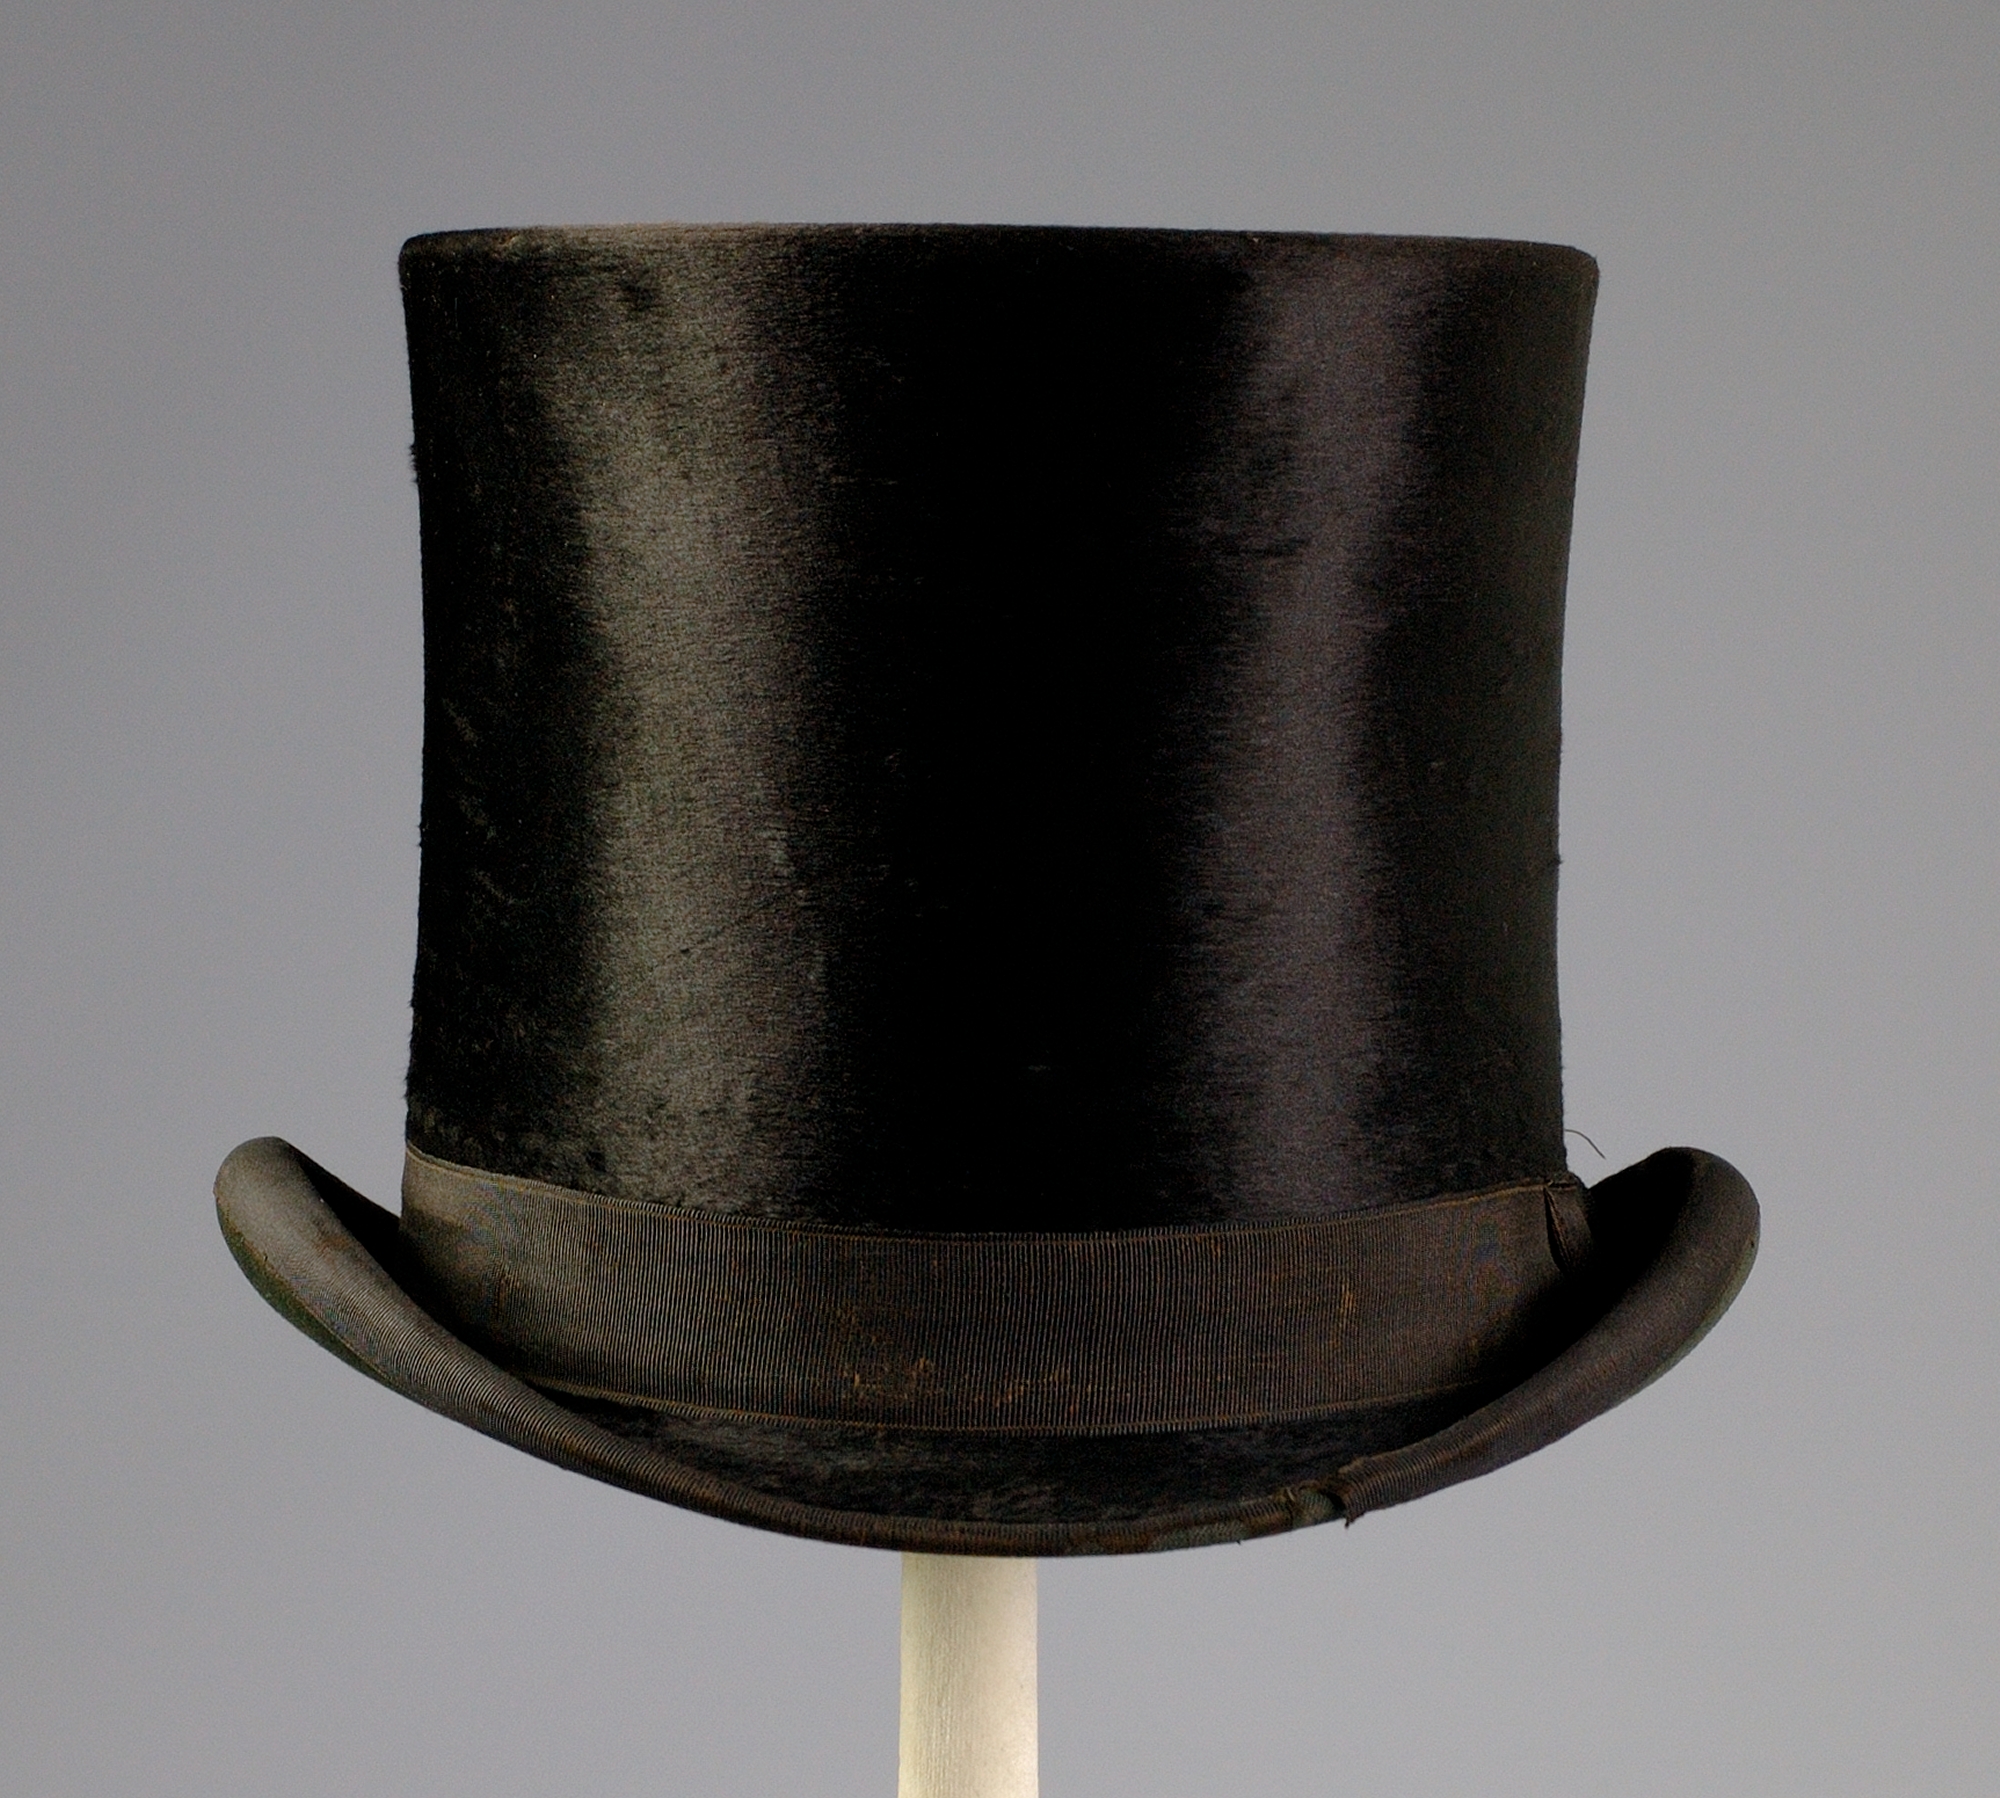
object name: top hat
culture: british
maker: melton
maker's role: maker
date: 1885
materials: fur, silk